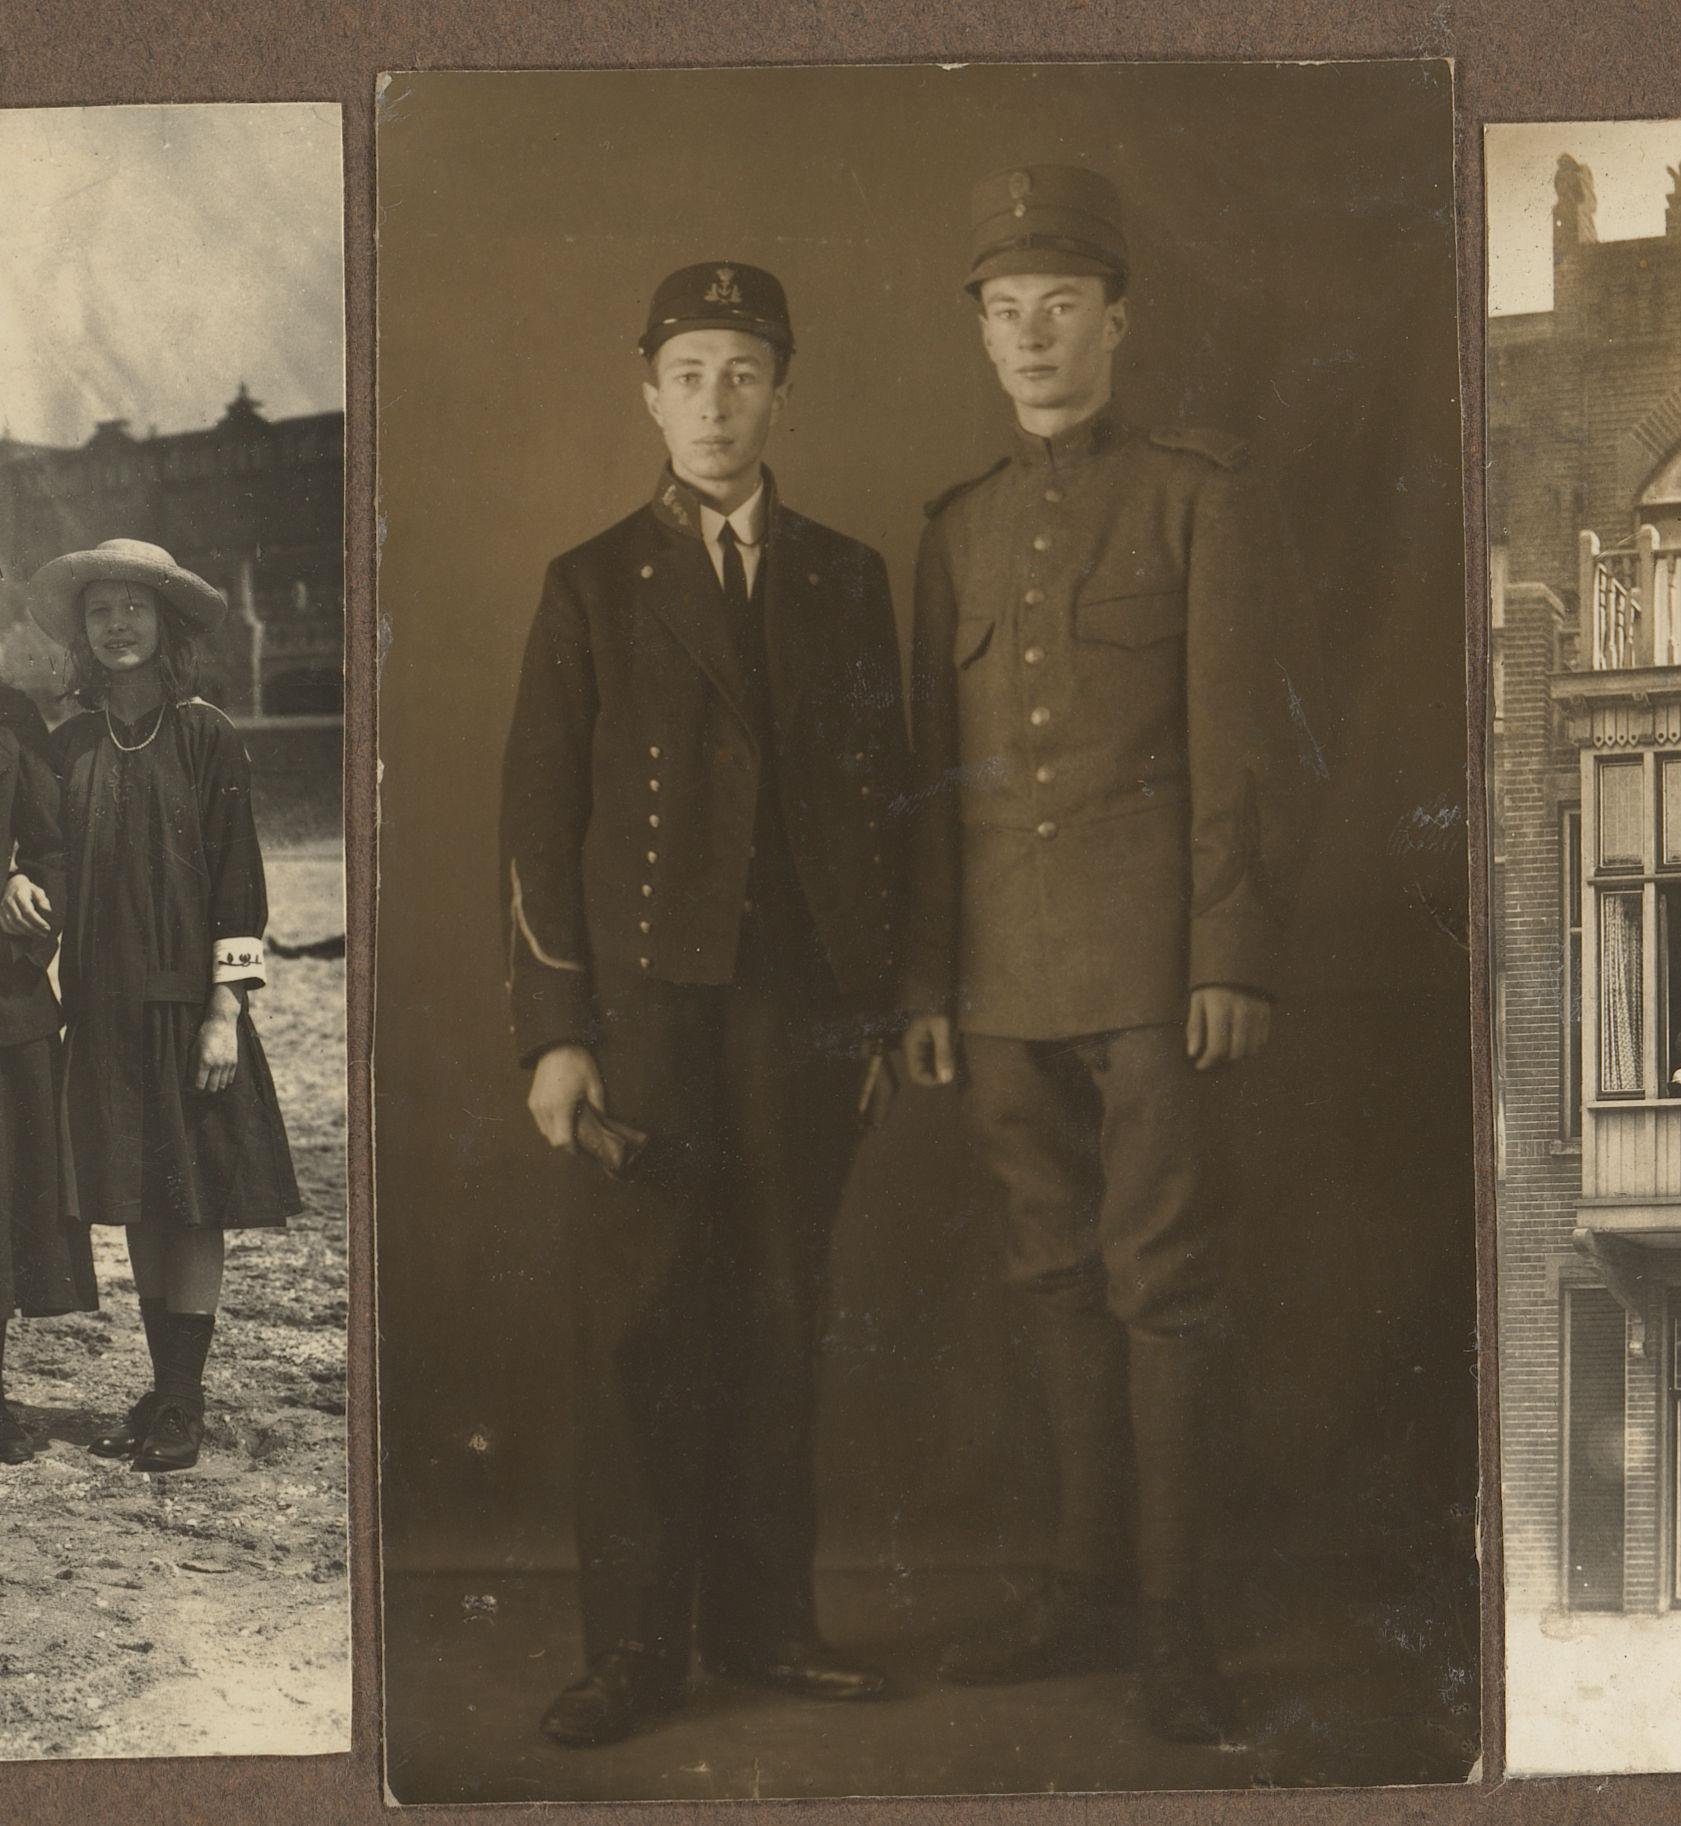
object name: photograph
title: Twee staande mannen met hoofddeksels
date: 1870-1920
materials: photographic support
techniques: photography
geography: amsterdam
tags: netherlands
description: Foto op bruin albumblad 39 van familiealbum van Alphons Diepenbrock.